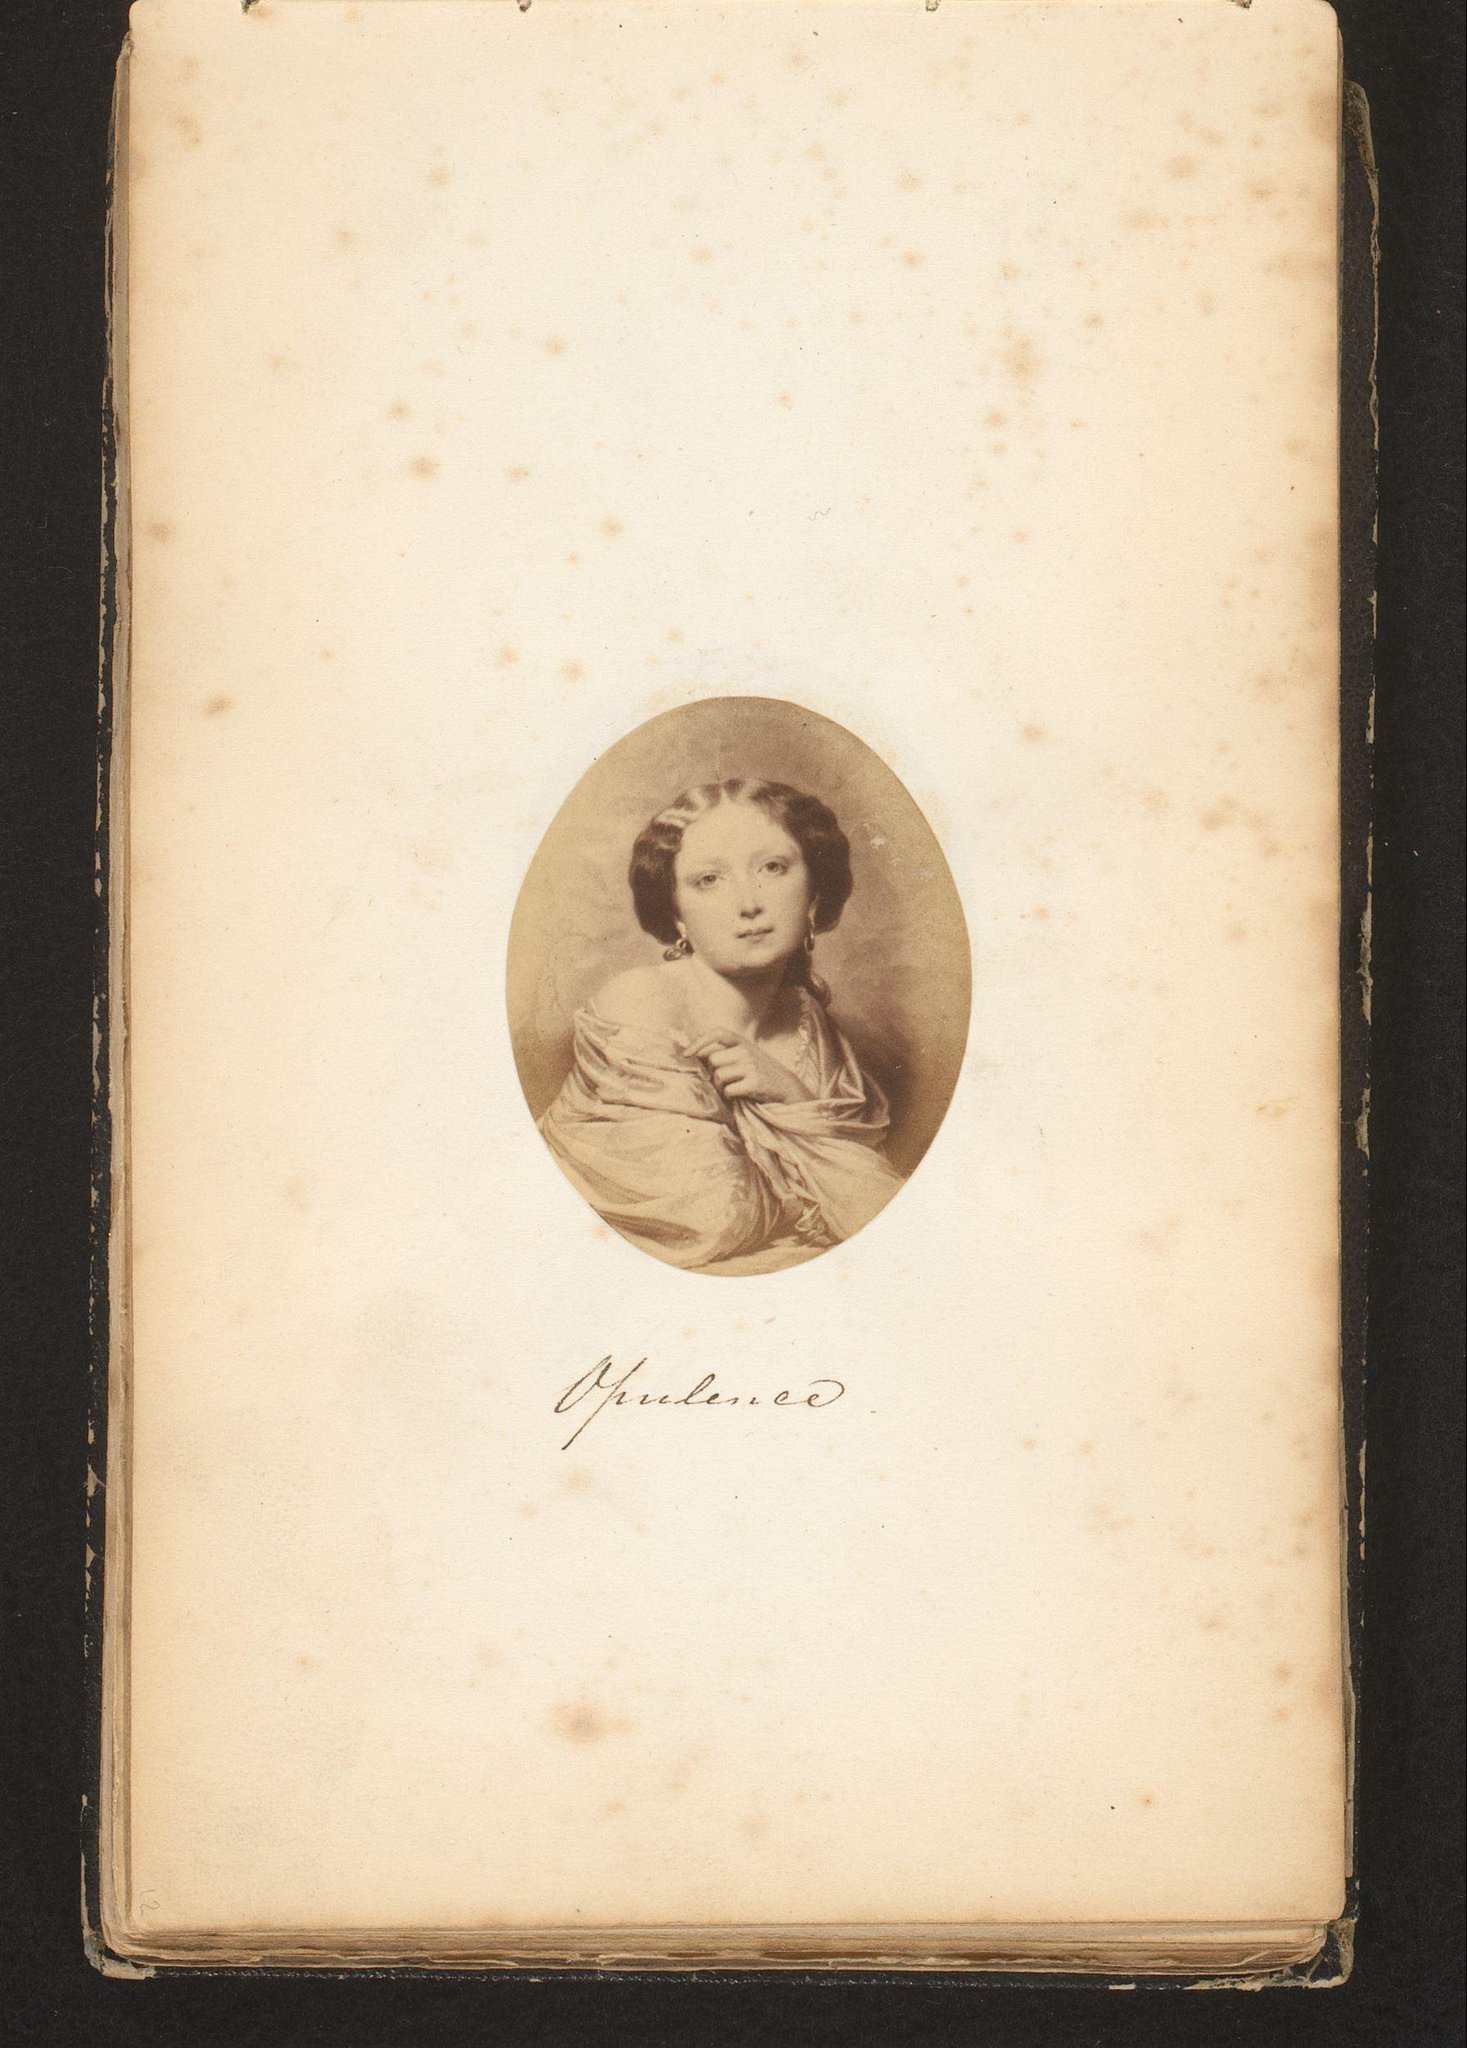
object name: album leaf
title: Fotoreproductie van een geschilderd portret van een vrouw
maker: Anonymous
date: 1860-1900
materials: photographic support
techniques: albumen print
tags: adult woman, ear-rings, painting, drawing and the graphic arts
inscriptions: annotation: ‘Opulence’